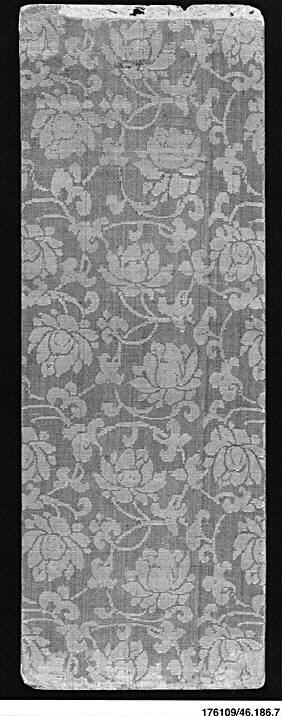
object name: sutra cover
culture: chinese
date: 1601-1700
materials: silk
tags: lotuses